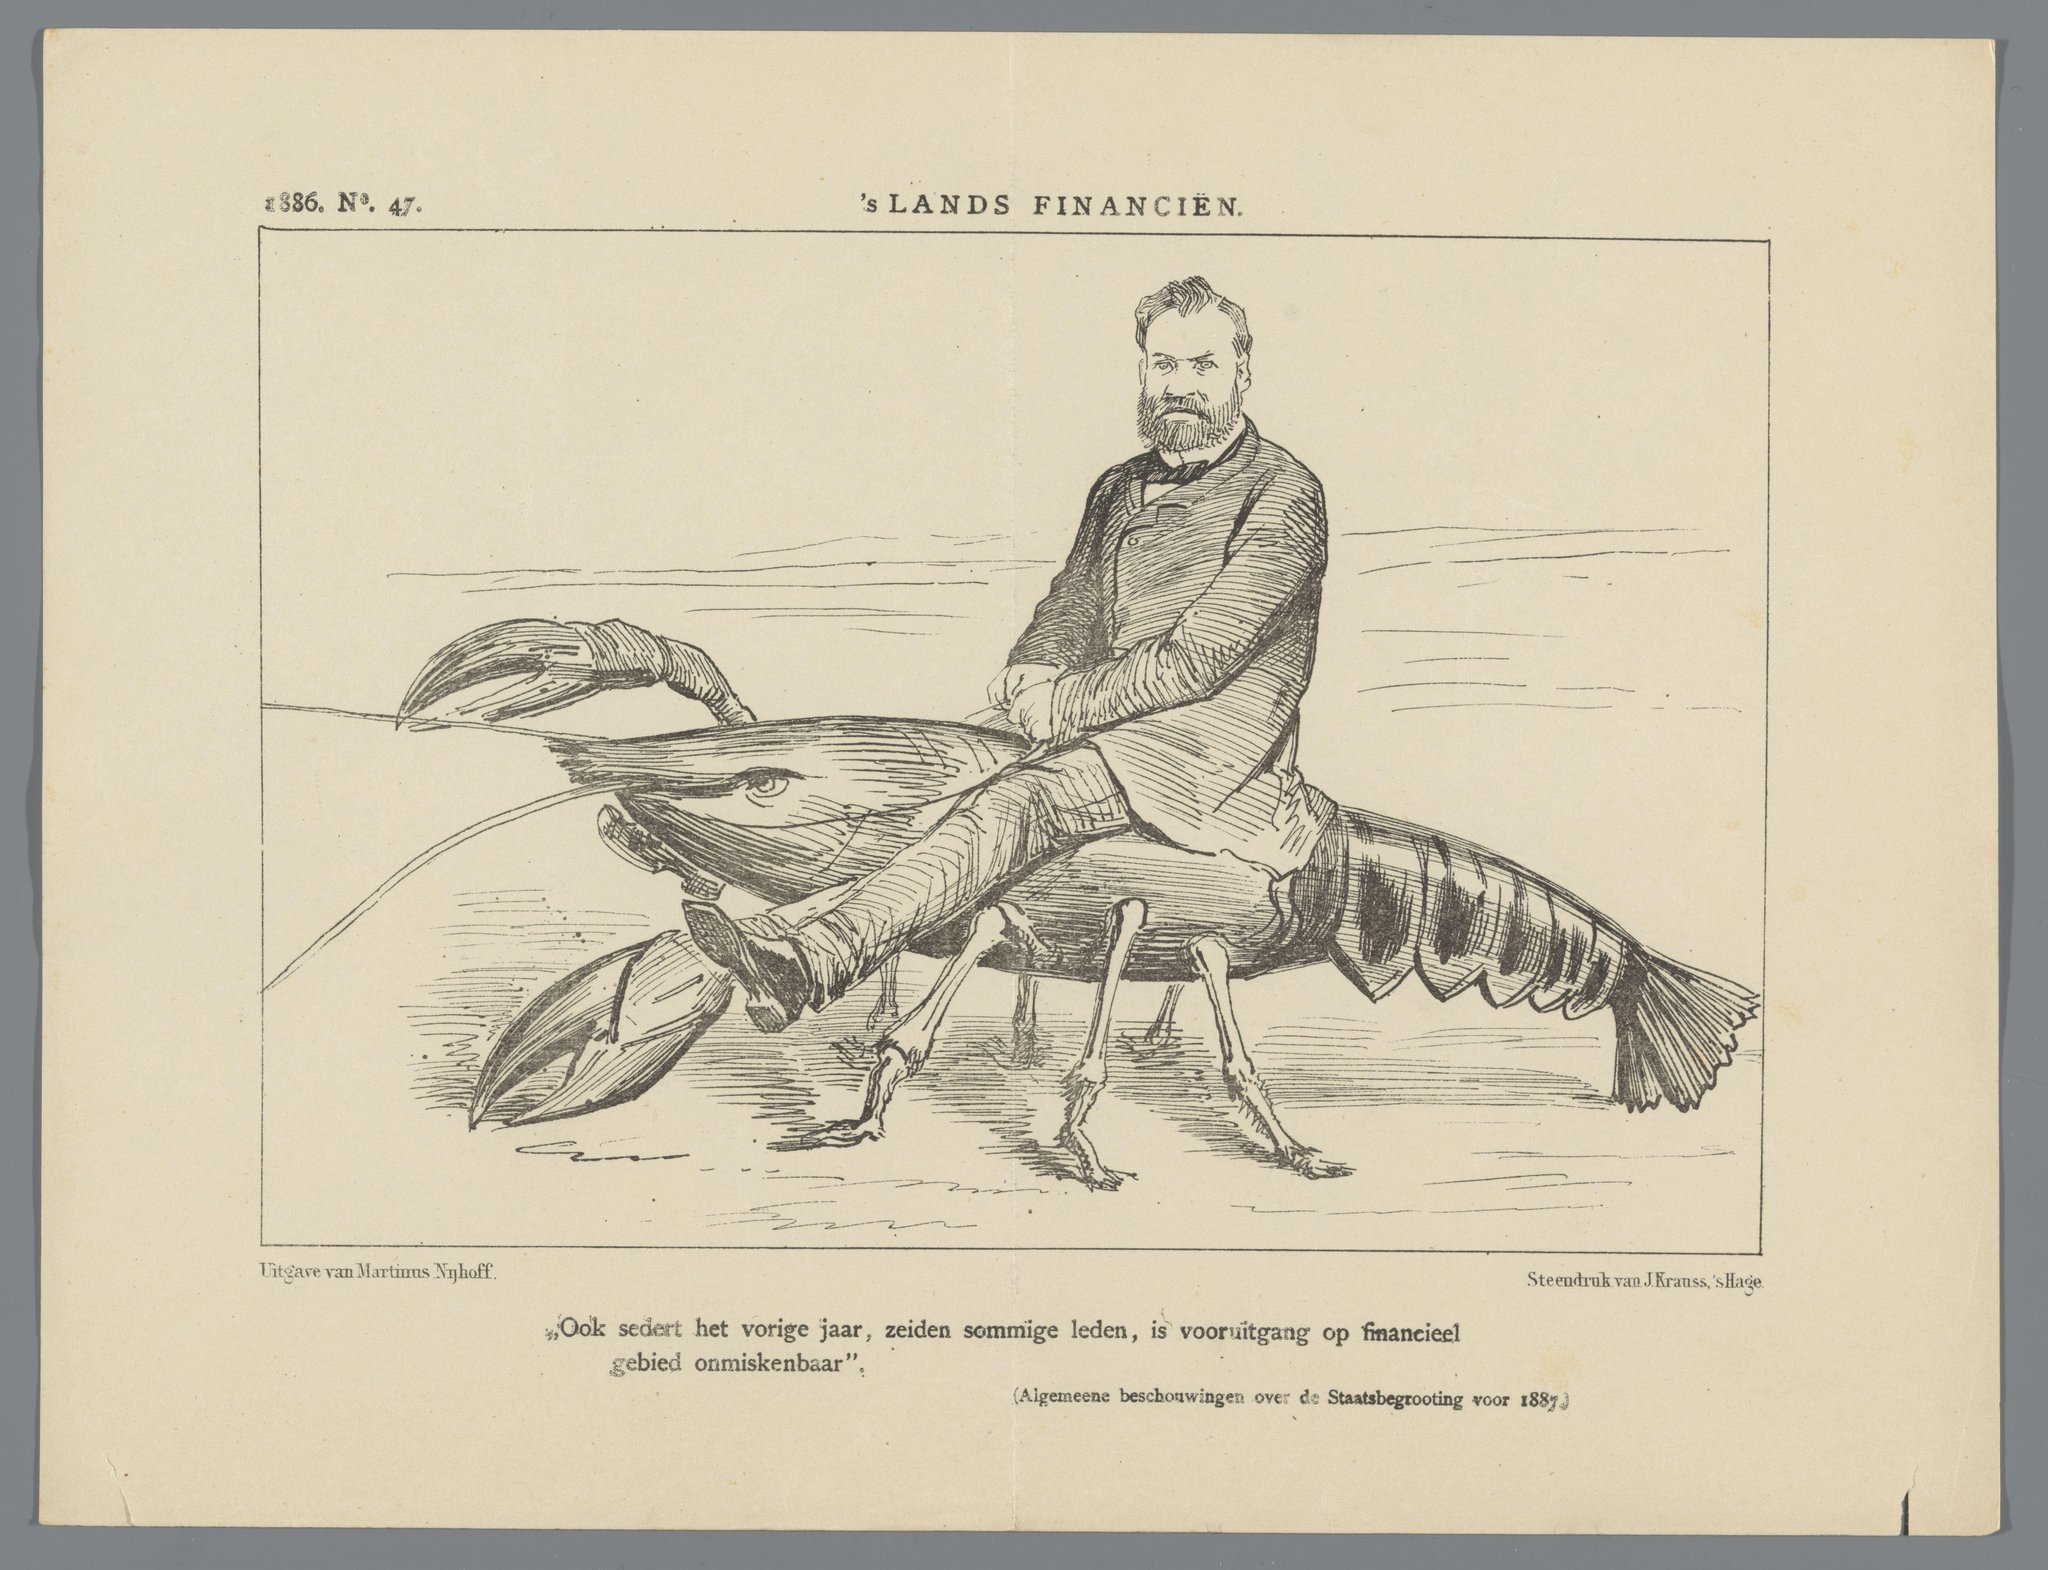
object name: print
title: Spotprent met minister Bloem op een kreeft, 1886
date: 1886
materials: paper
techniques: lithograph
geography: the hague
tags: crustaceans: lobster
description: Spotprent met Minister van Financiën Bloem zittend op een kreeft. Plaat verschenen bij het weekblad De Nederlandsche Spectator, nr. 47, 1886.